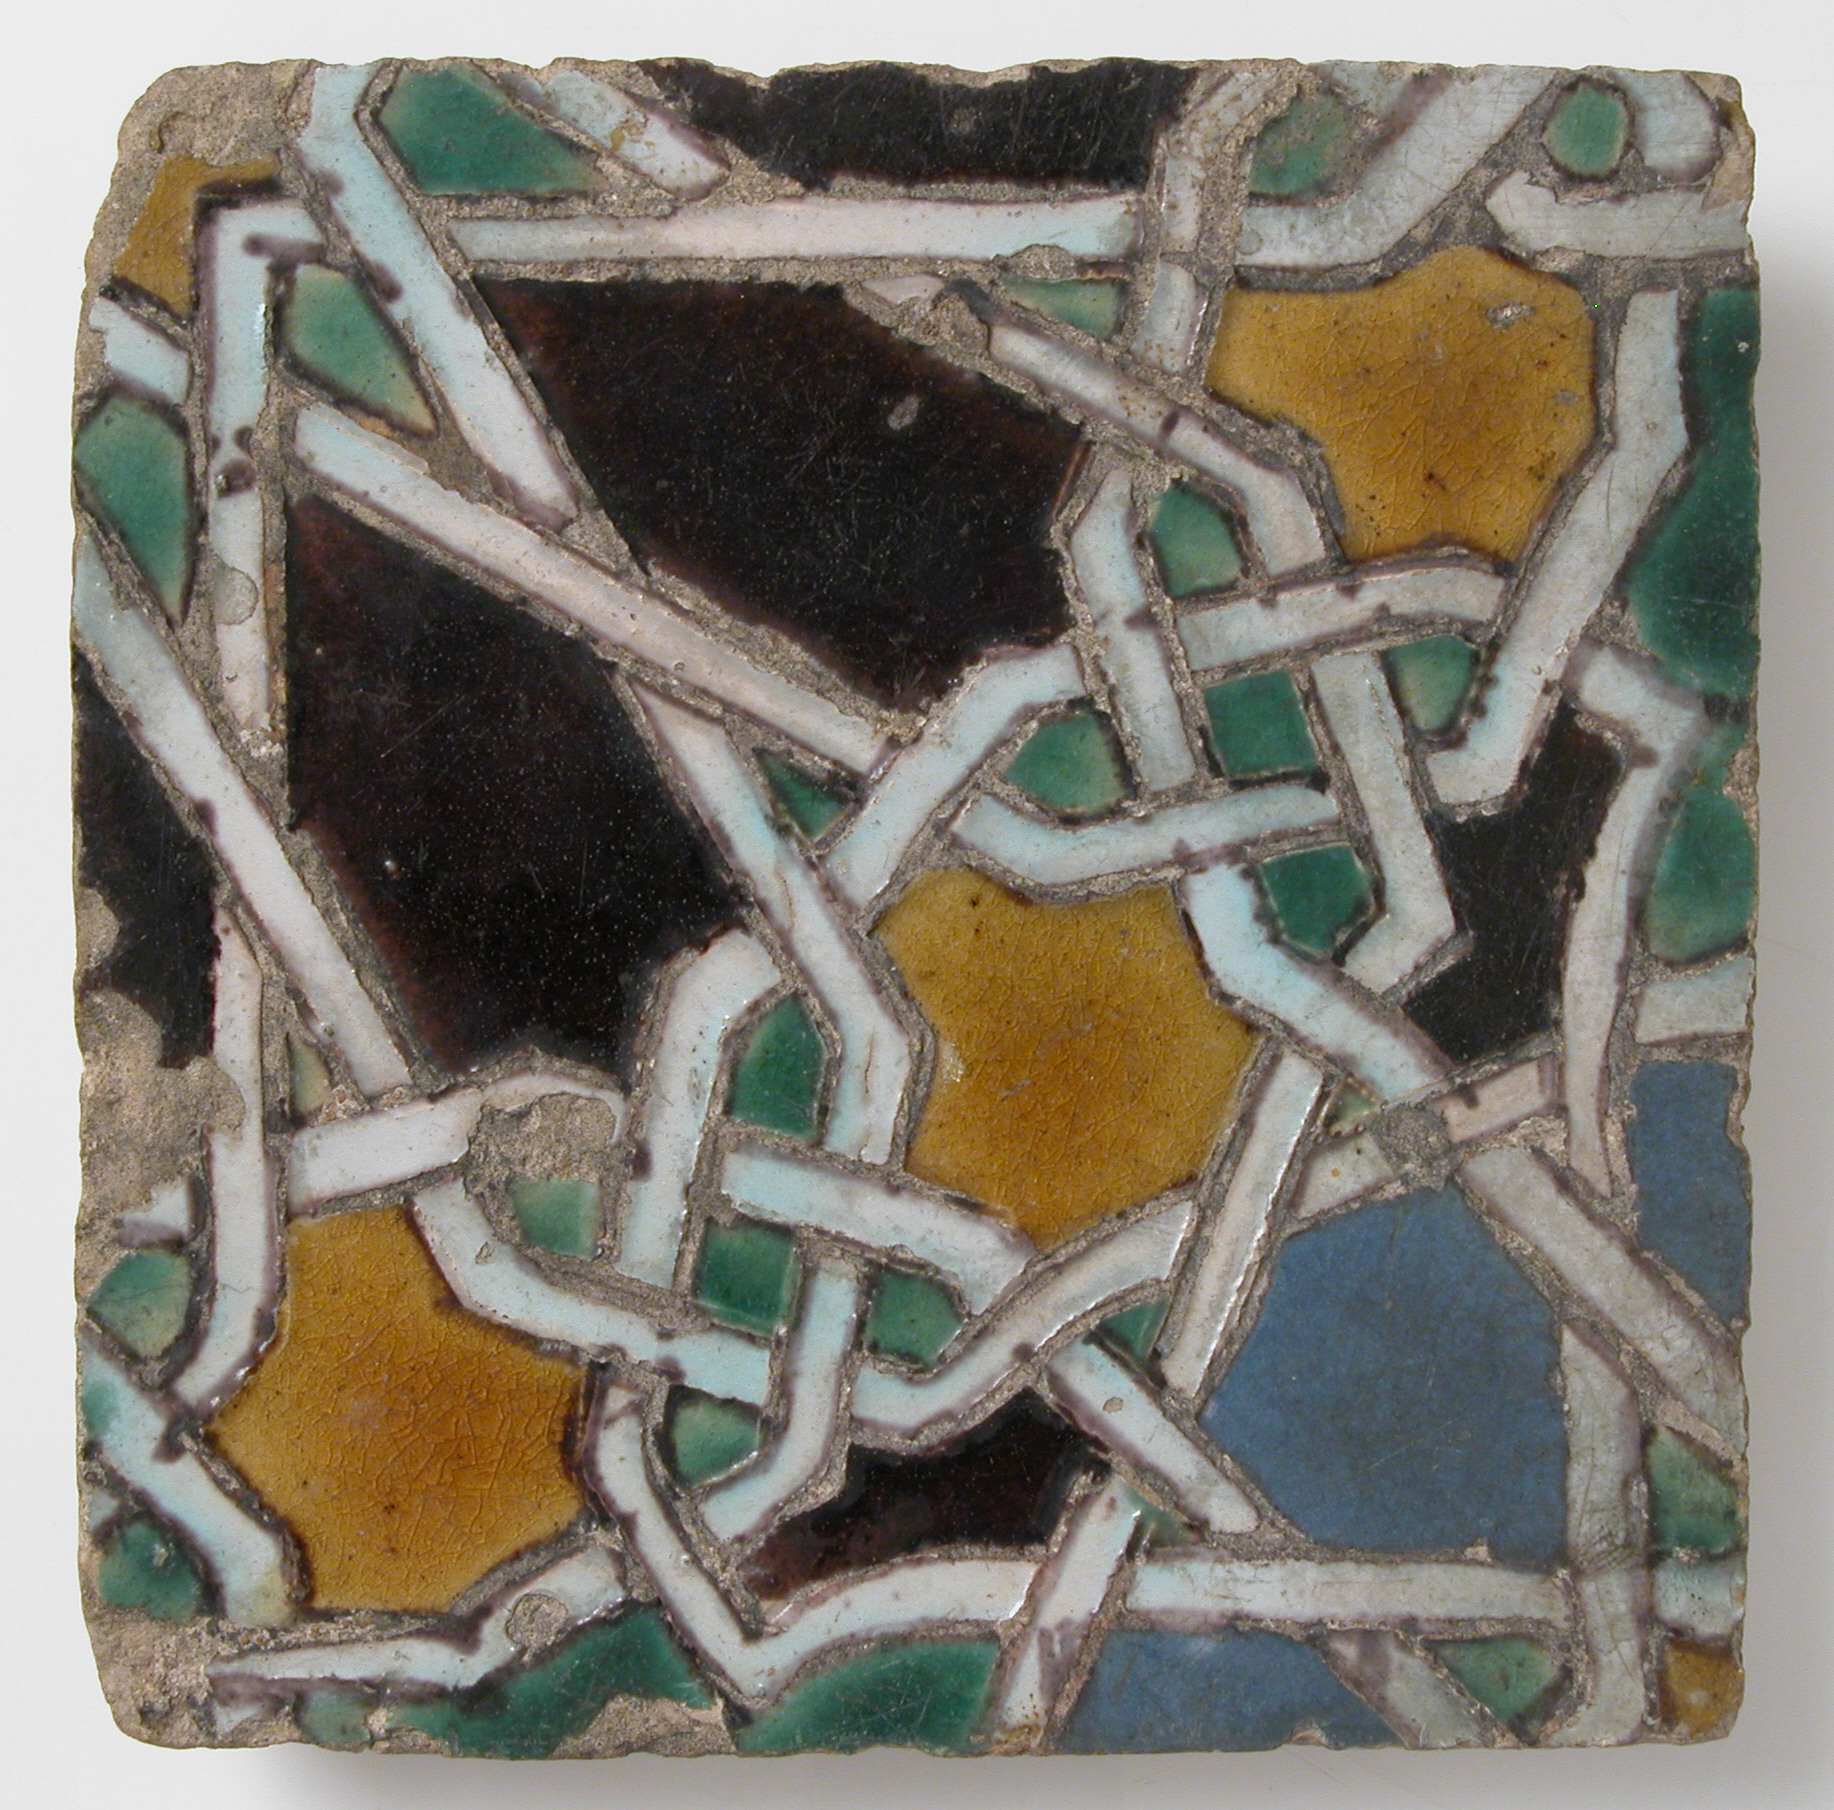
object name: tile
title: Wall Tile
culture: spanish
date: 1401-1500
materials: earthenware, glaze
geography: spain